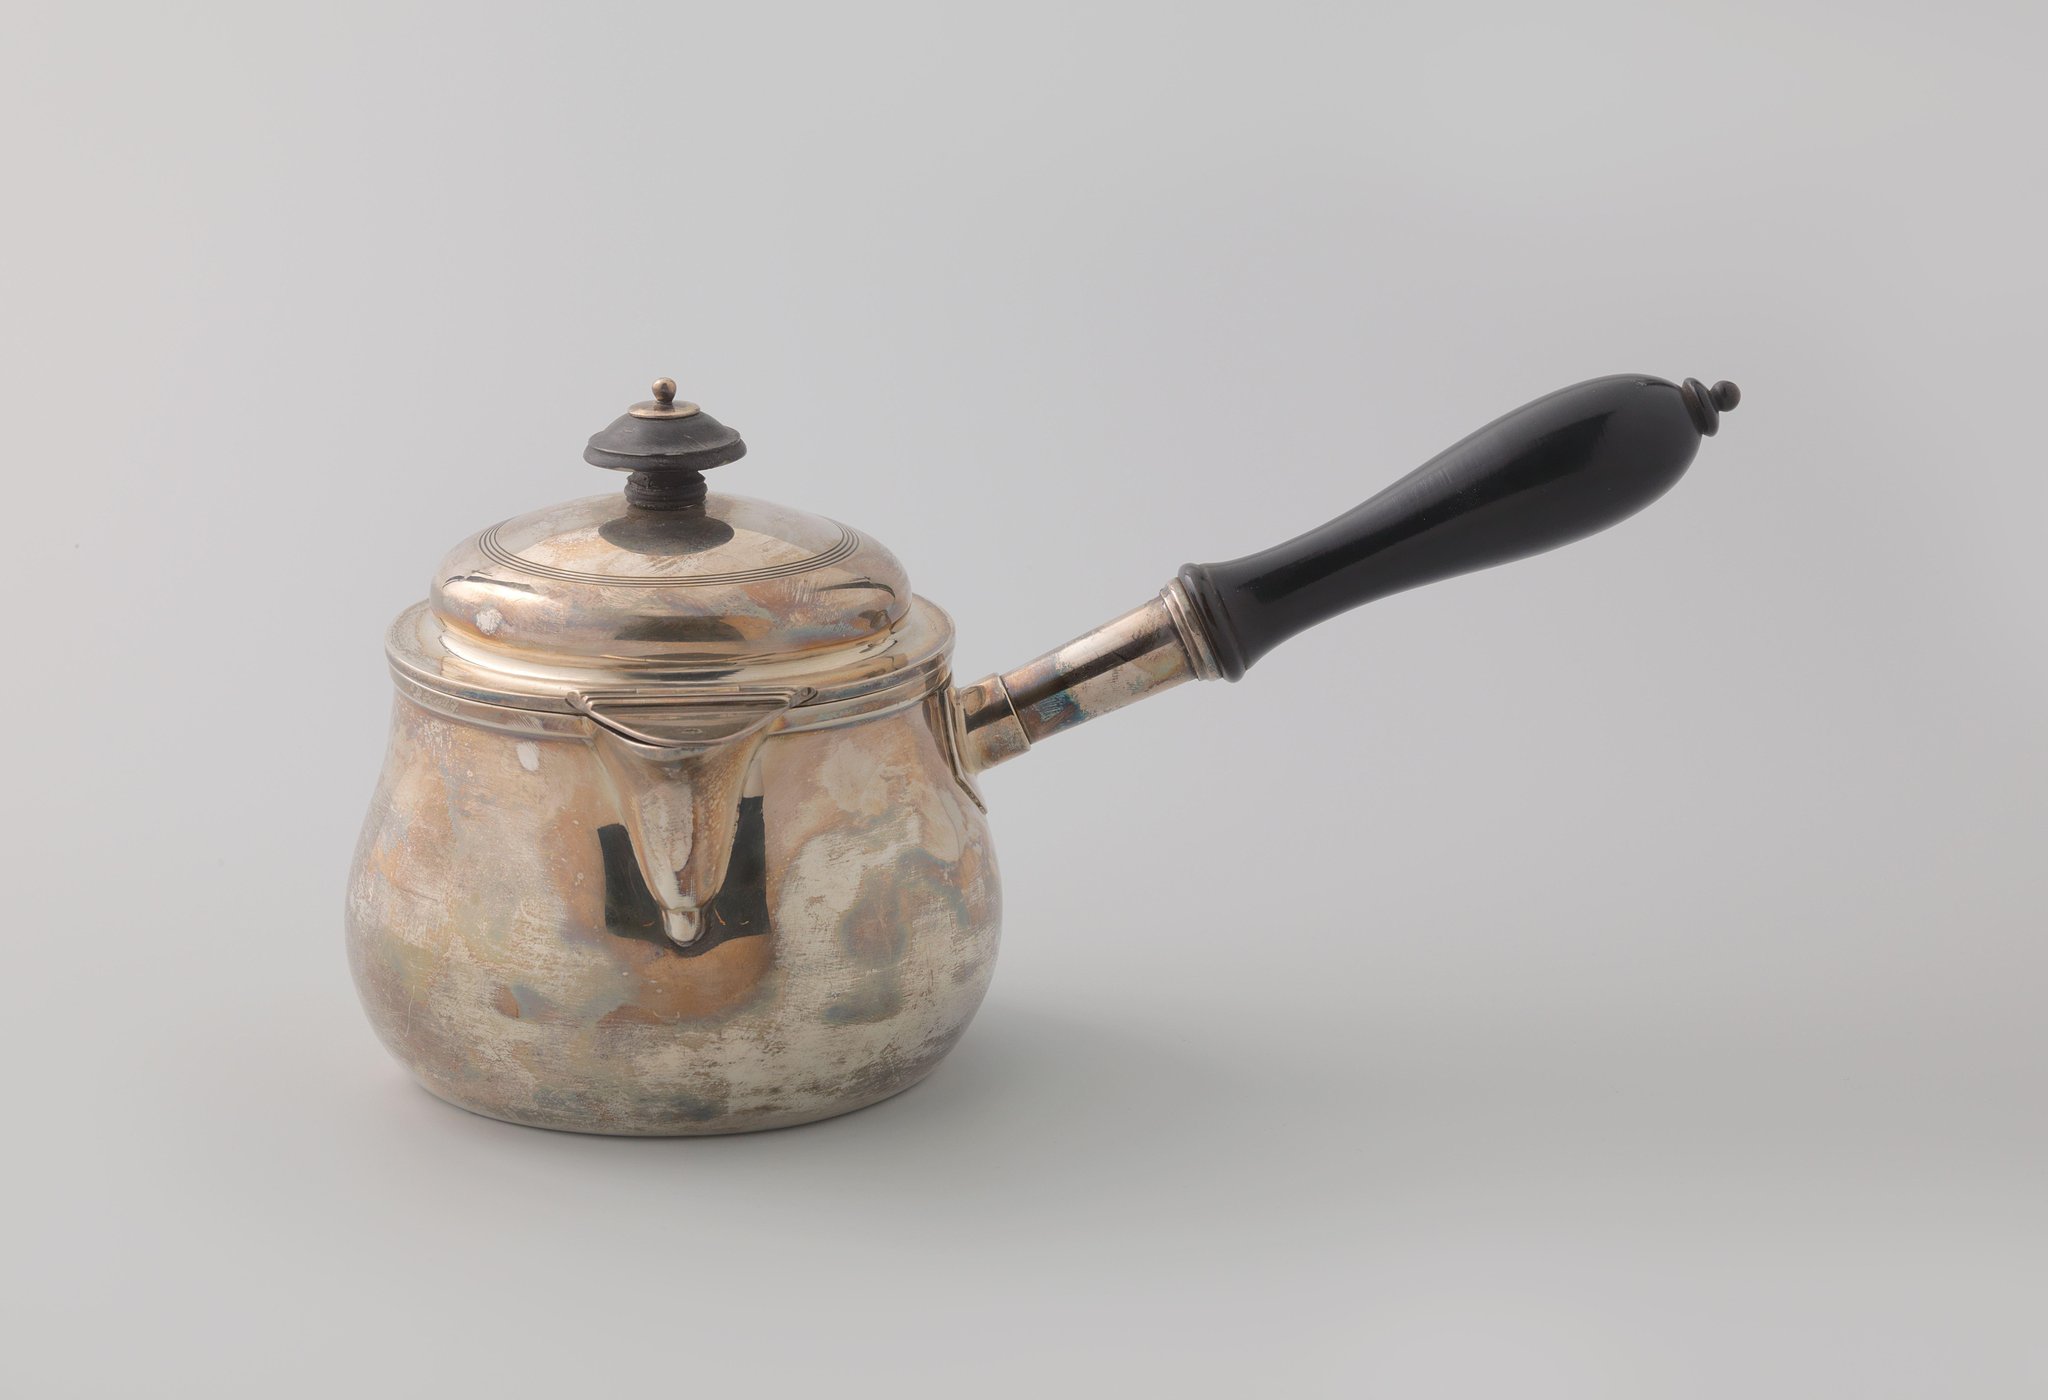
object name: stockpot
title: Pan van zilver. Het ronde onversierde vat met lange ebbenhouten steel is aan de onderkant enigszins verbreed. Met deksel en scharnierende klep voor de tuit.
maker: samuel whitford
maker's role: silversmith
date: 1818-1819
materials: wood, silver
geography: london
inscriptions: mark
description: Pan van zilver. Het ronde onversierde vat met lange ebbenhouten steel is aan de onderkant enigszins verbreed. Met deksel en scharnierende klep voor de tuit.